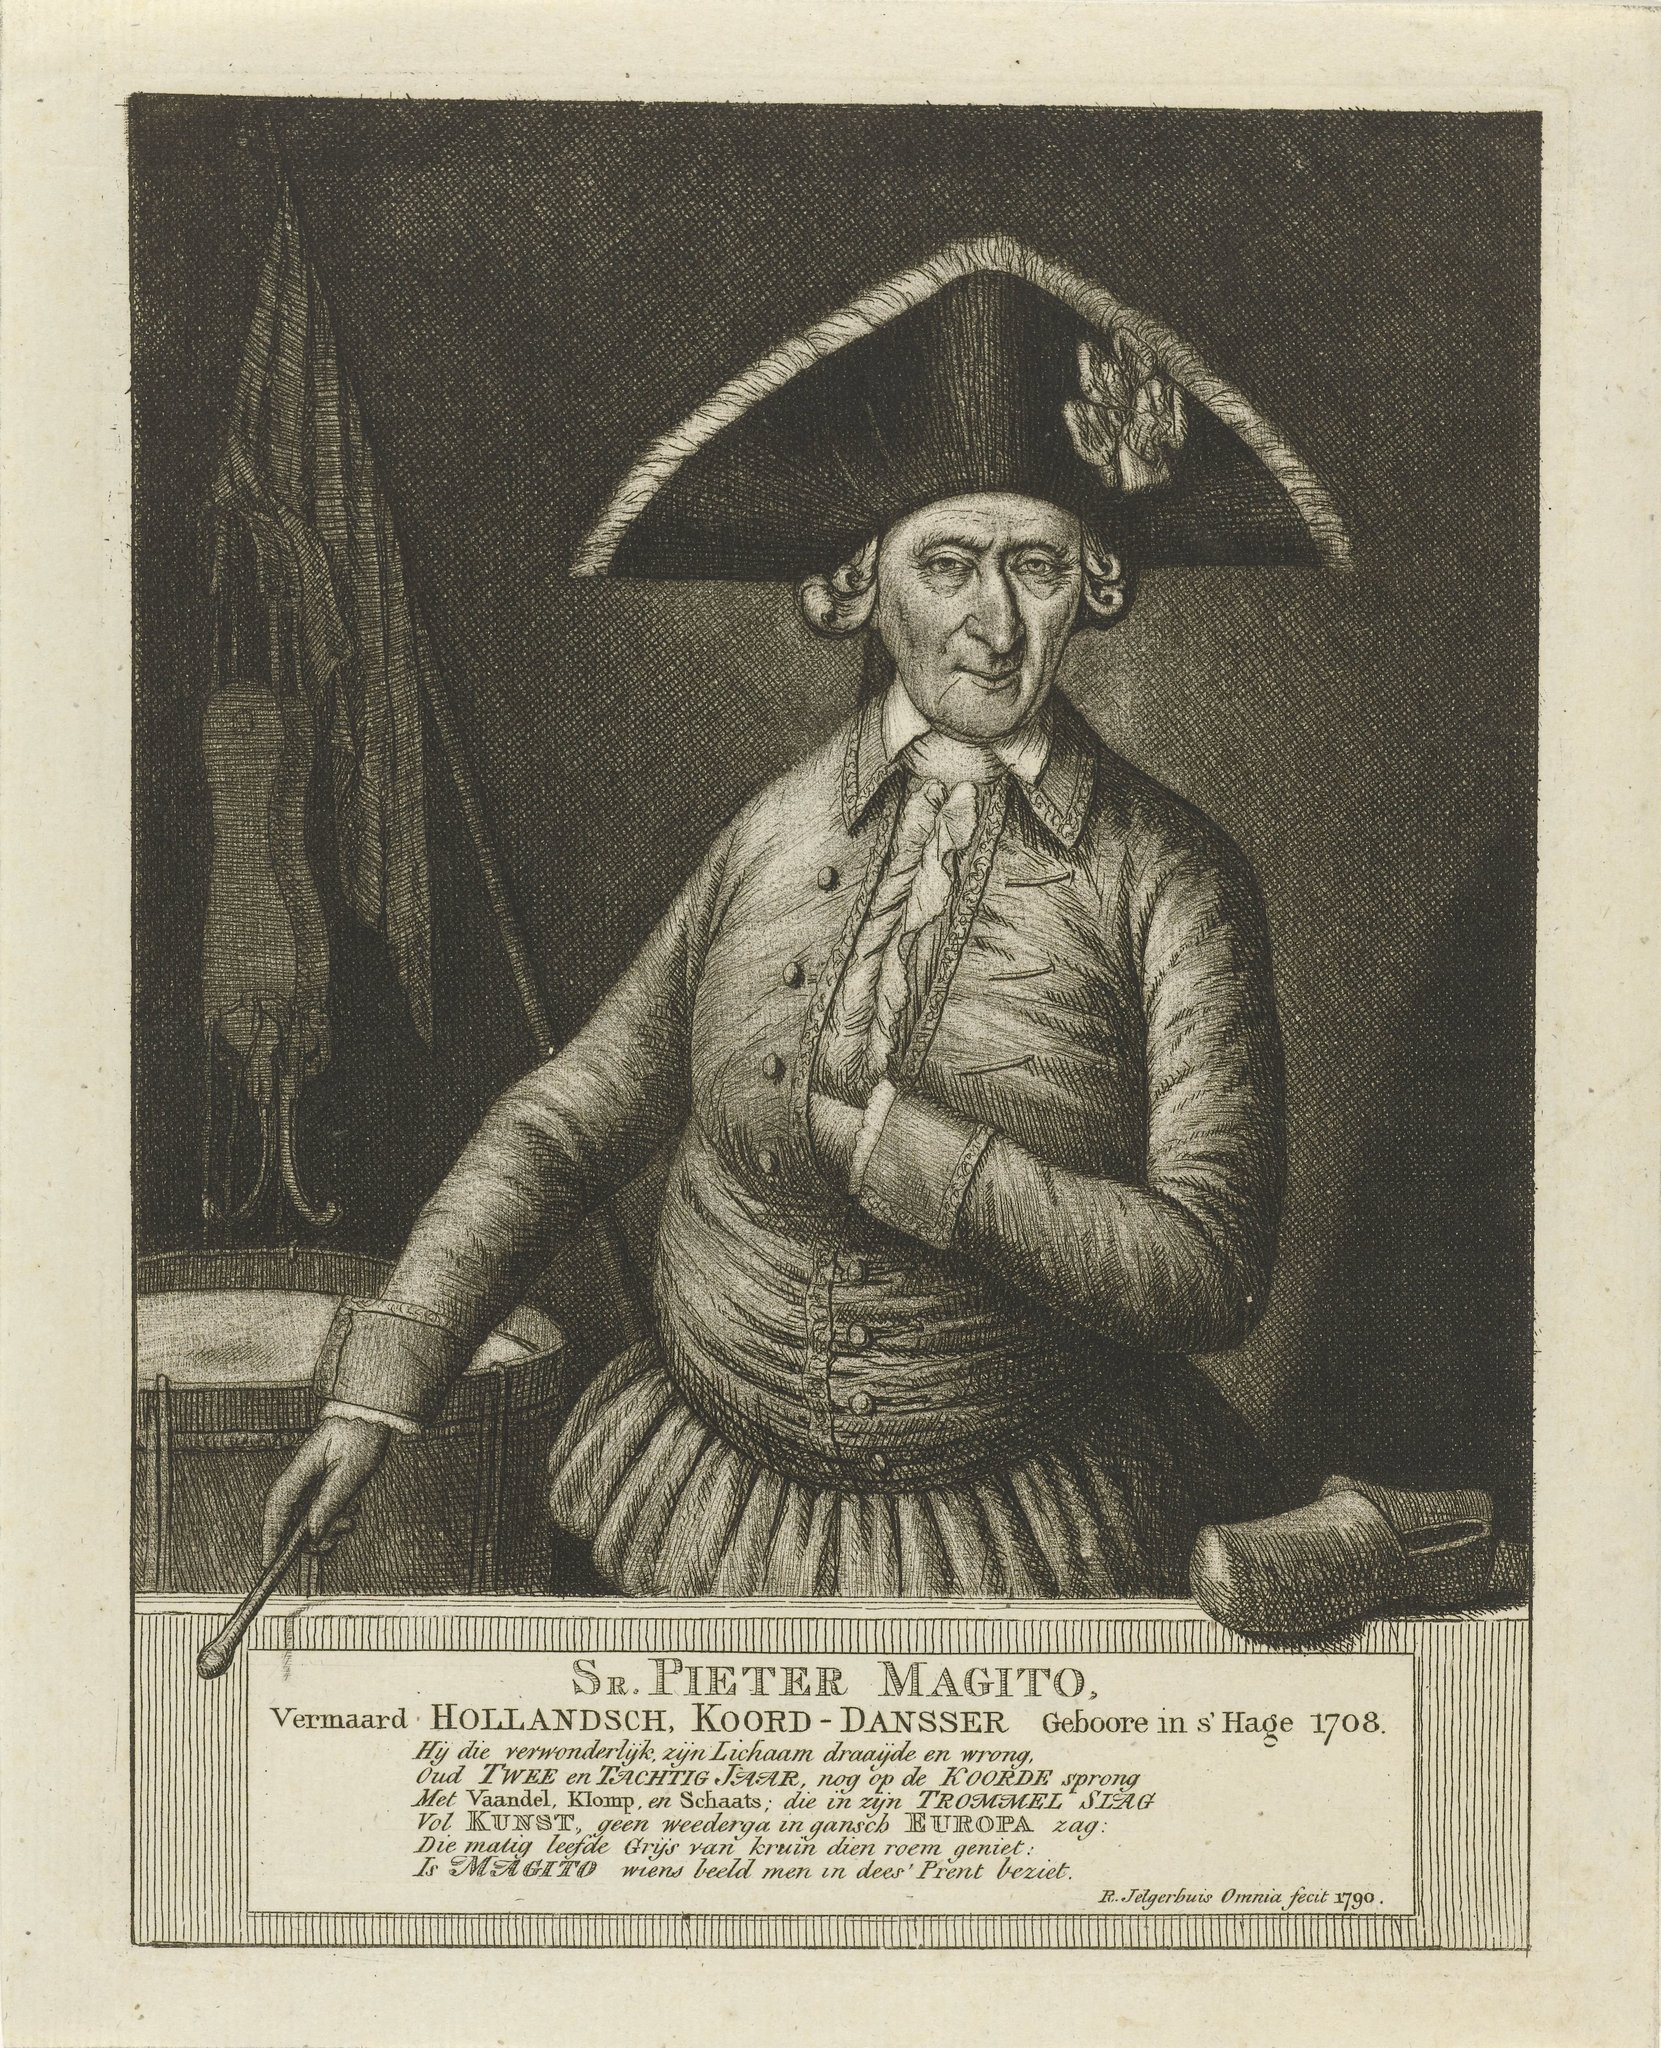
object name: print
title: Portret van Pieter Magito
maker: rienk jelgerhuis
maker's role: draughtsman, print maker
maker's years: 1729-1806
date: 1790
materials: paper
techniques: etching, sugar lift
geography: leeuwarden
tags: wooden shoes, clogs, drum (musical instrument)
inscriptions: collector's mark: Lugt 2760, collector's mark: Lugt 2228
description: Portret van de koorddanser Pieter Magito, met trommel, klompen en schaatsen. In het kader onder zijn portret zijn naam en beroep en een zesregelig gedicht in het Nederlands.